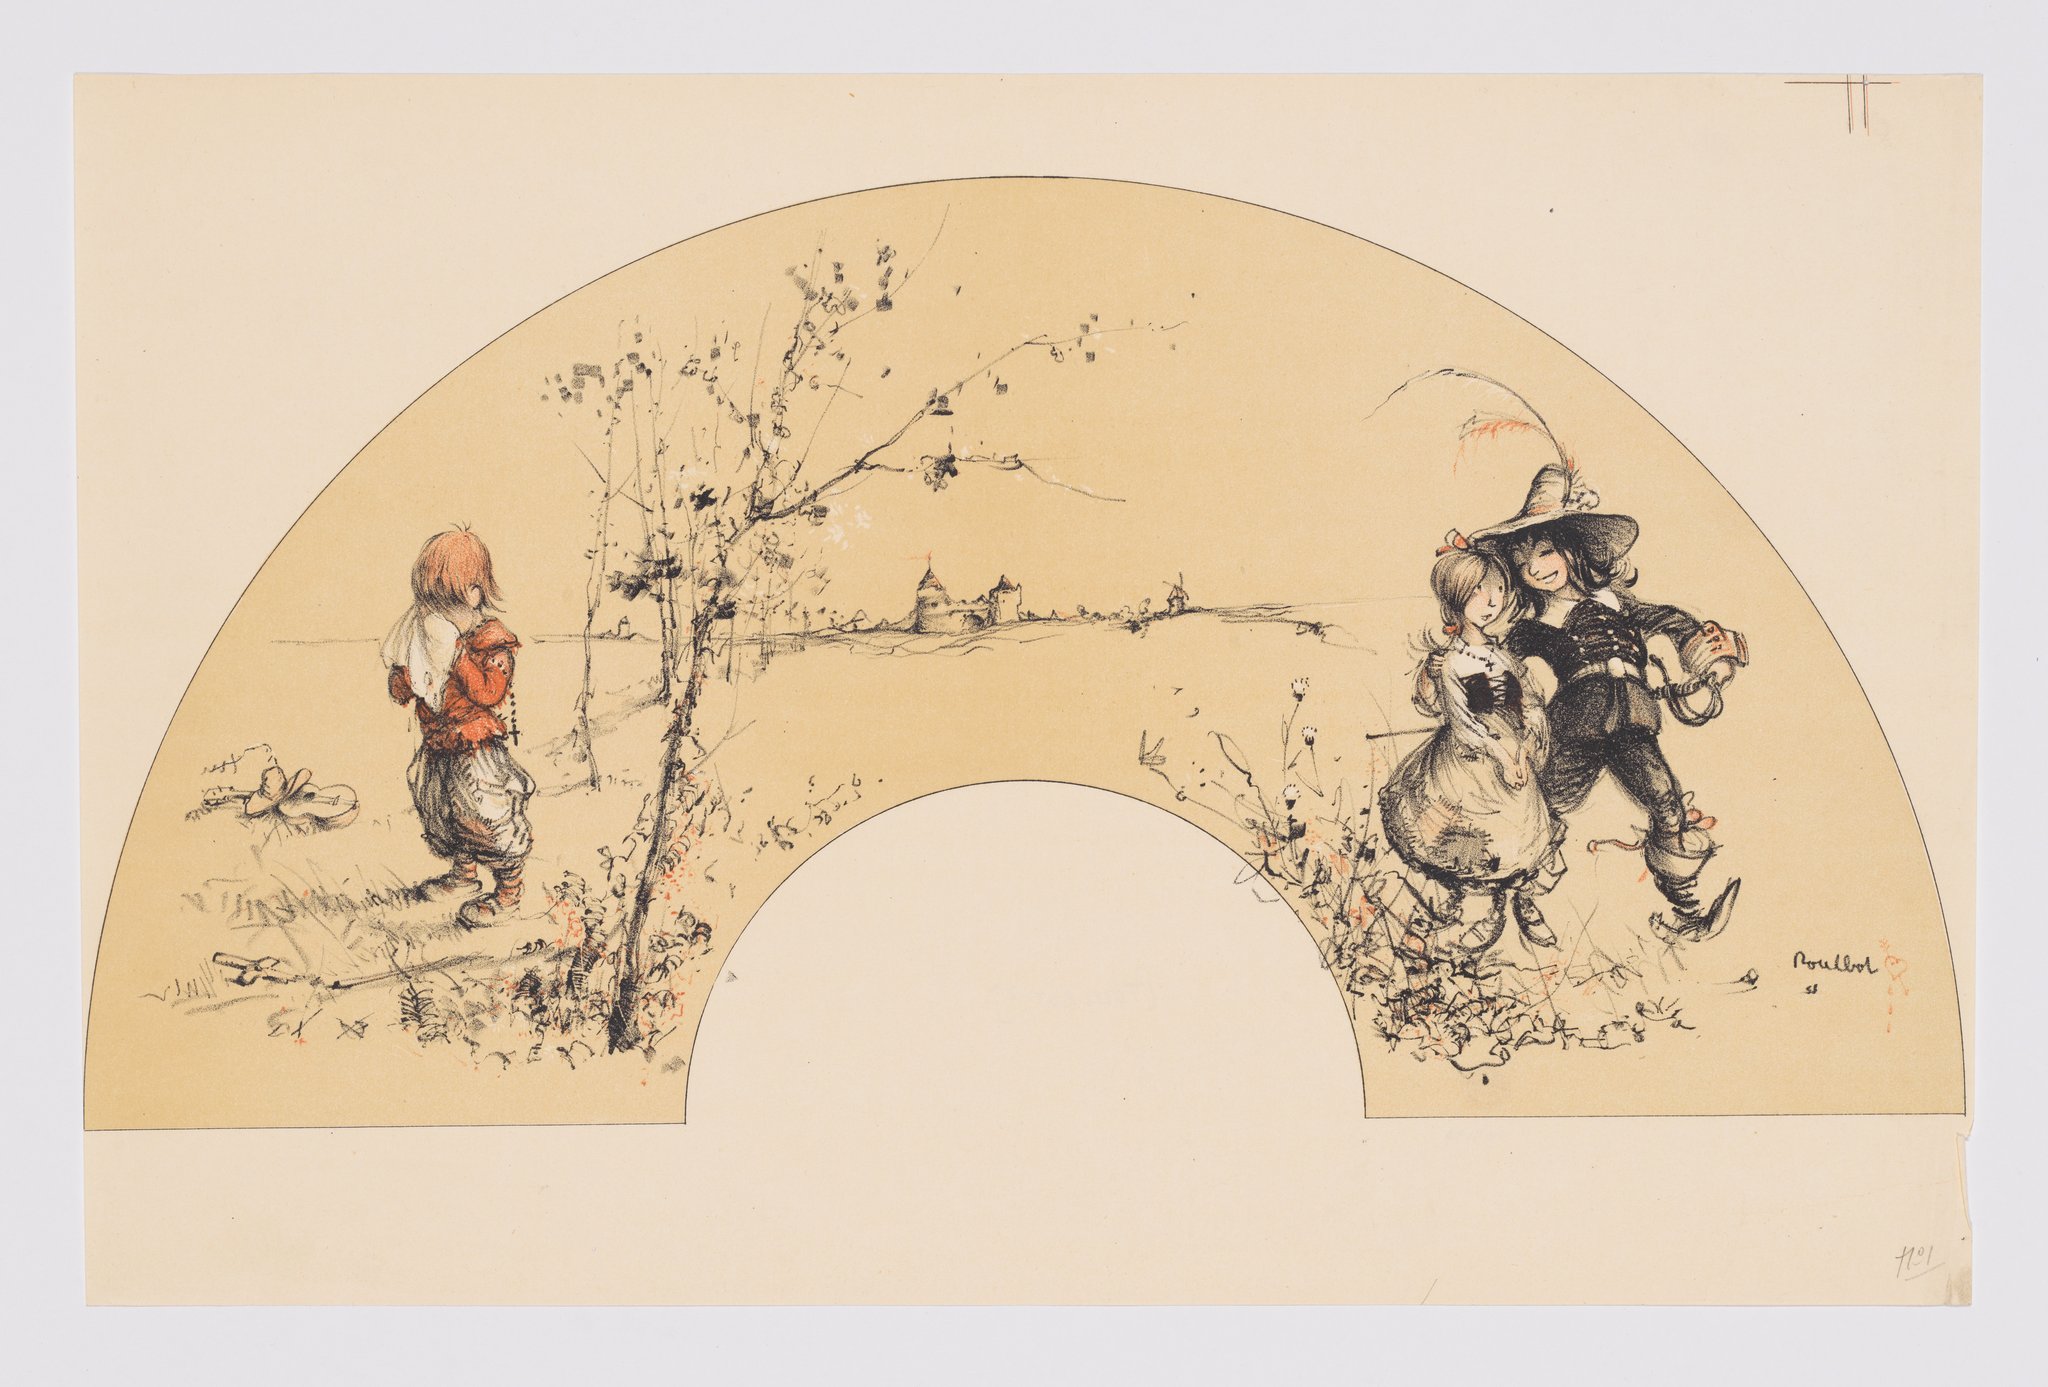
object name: print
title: Fan leaf depicting little boy weeping because another has his girl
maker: anonymous, french, 20th century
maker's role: artist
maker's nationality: french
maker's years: 1900-2000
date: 1904-1905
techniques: lithograph, printing